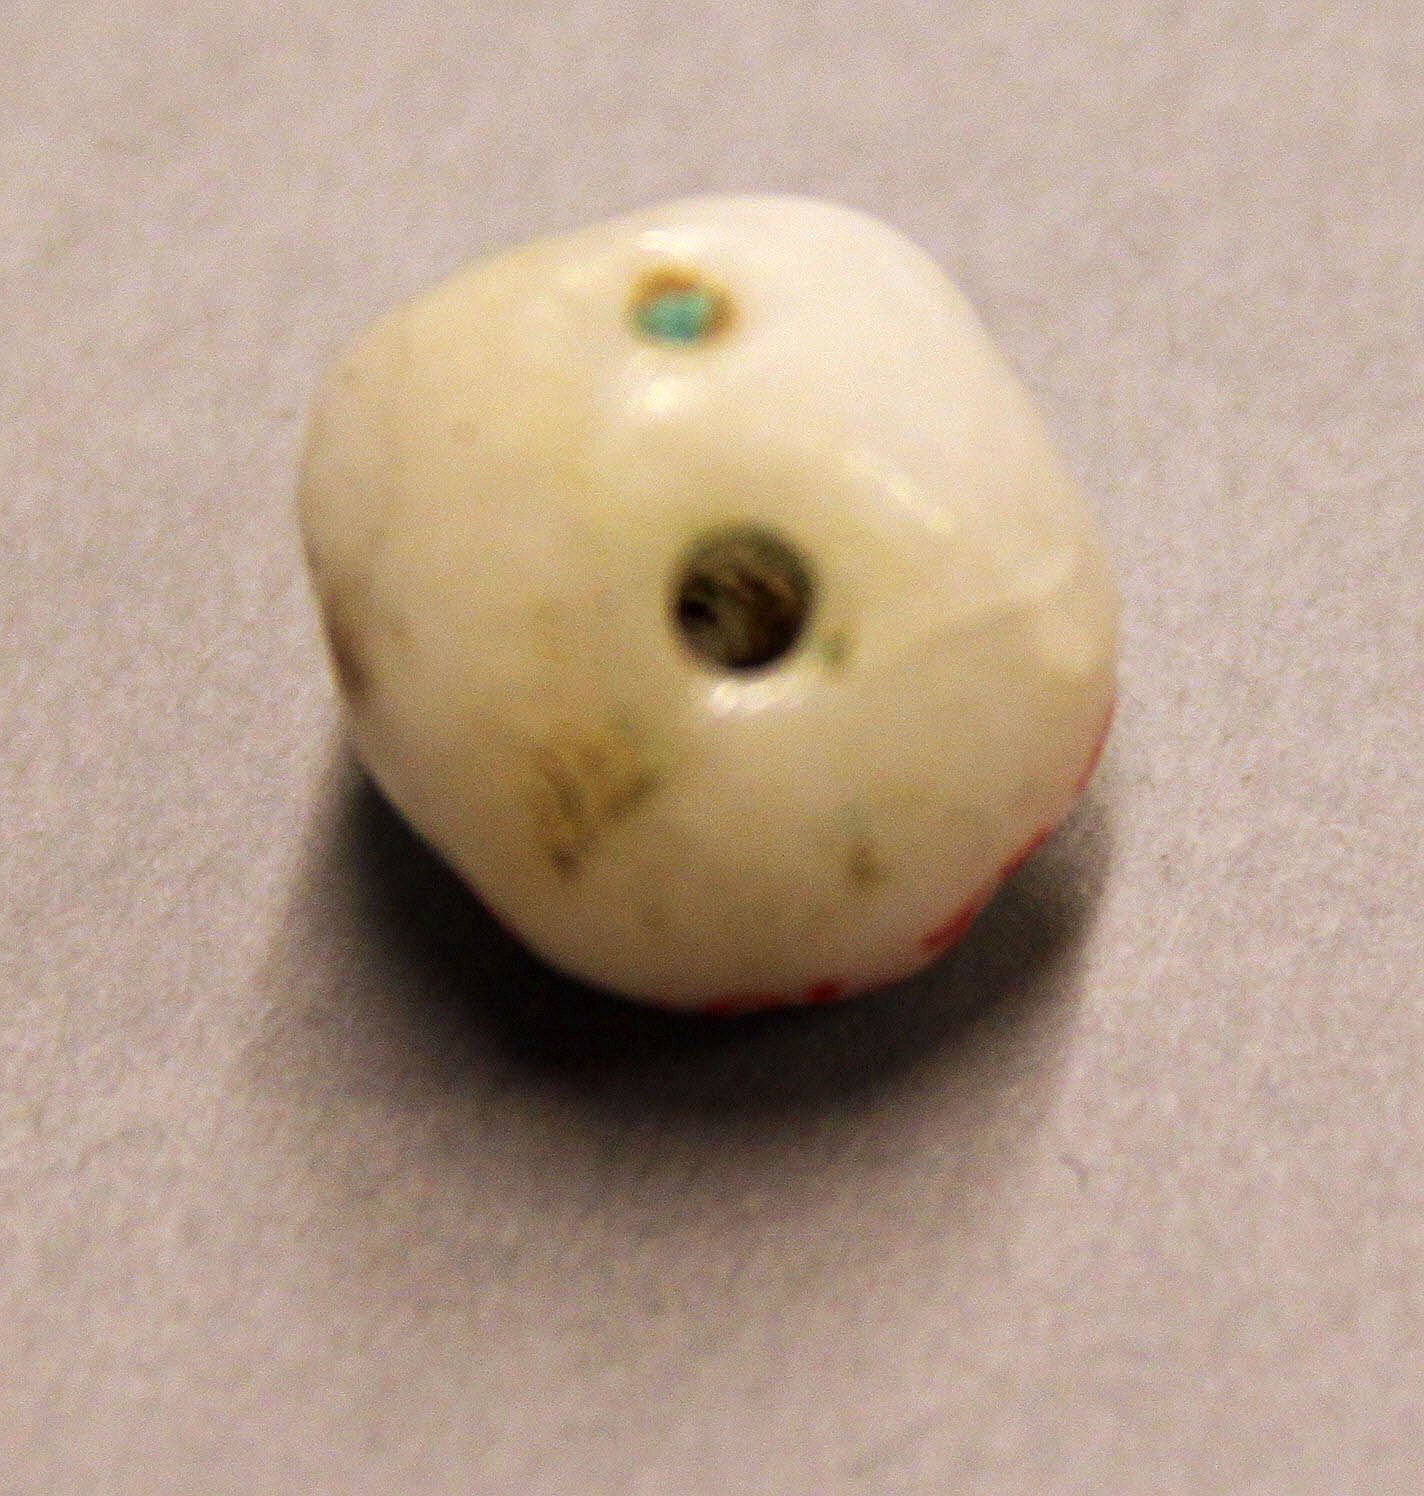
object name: bead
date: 701-1200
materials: stone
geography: iran